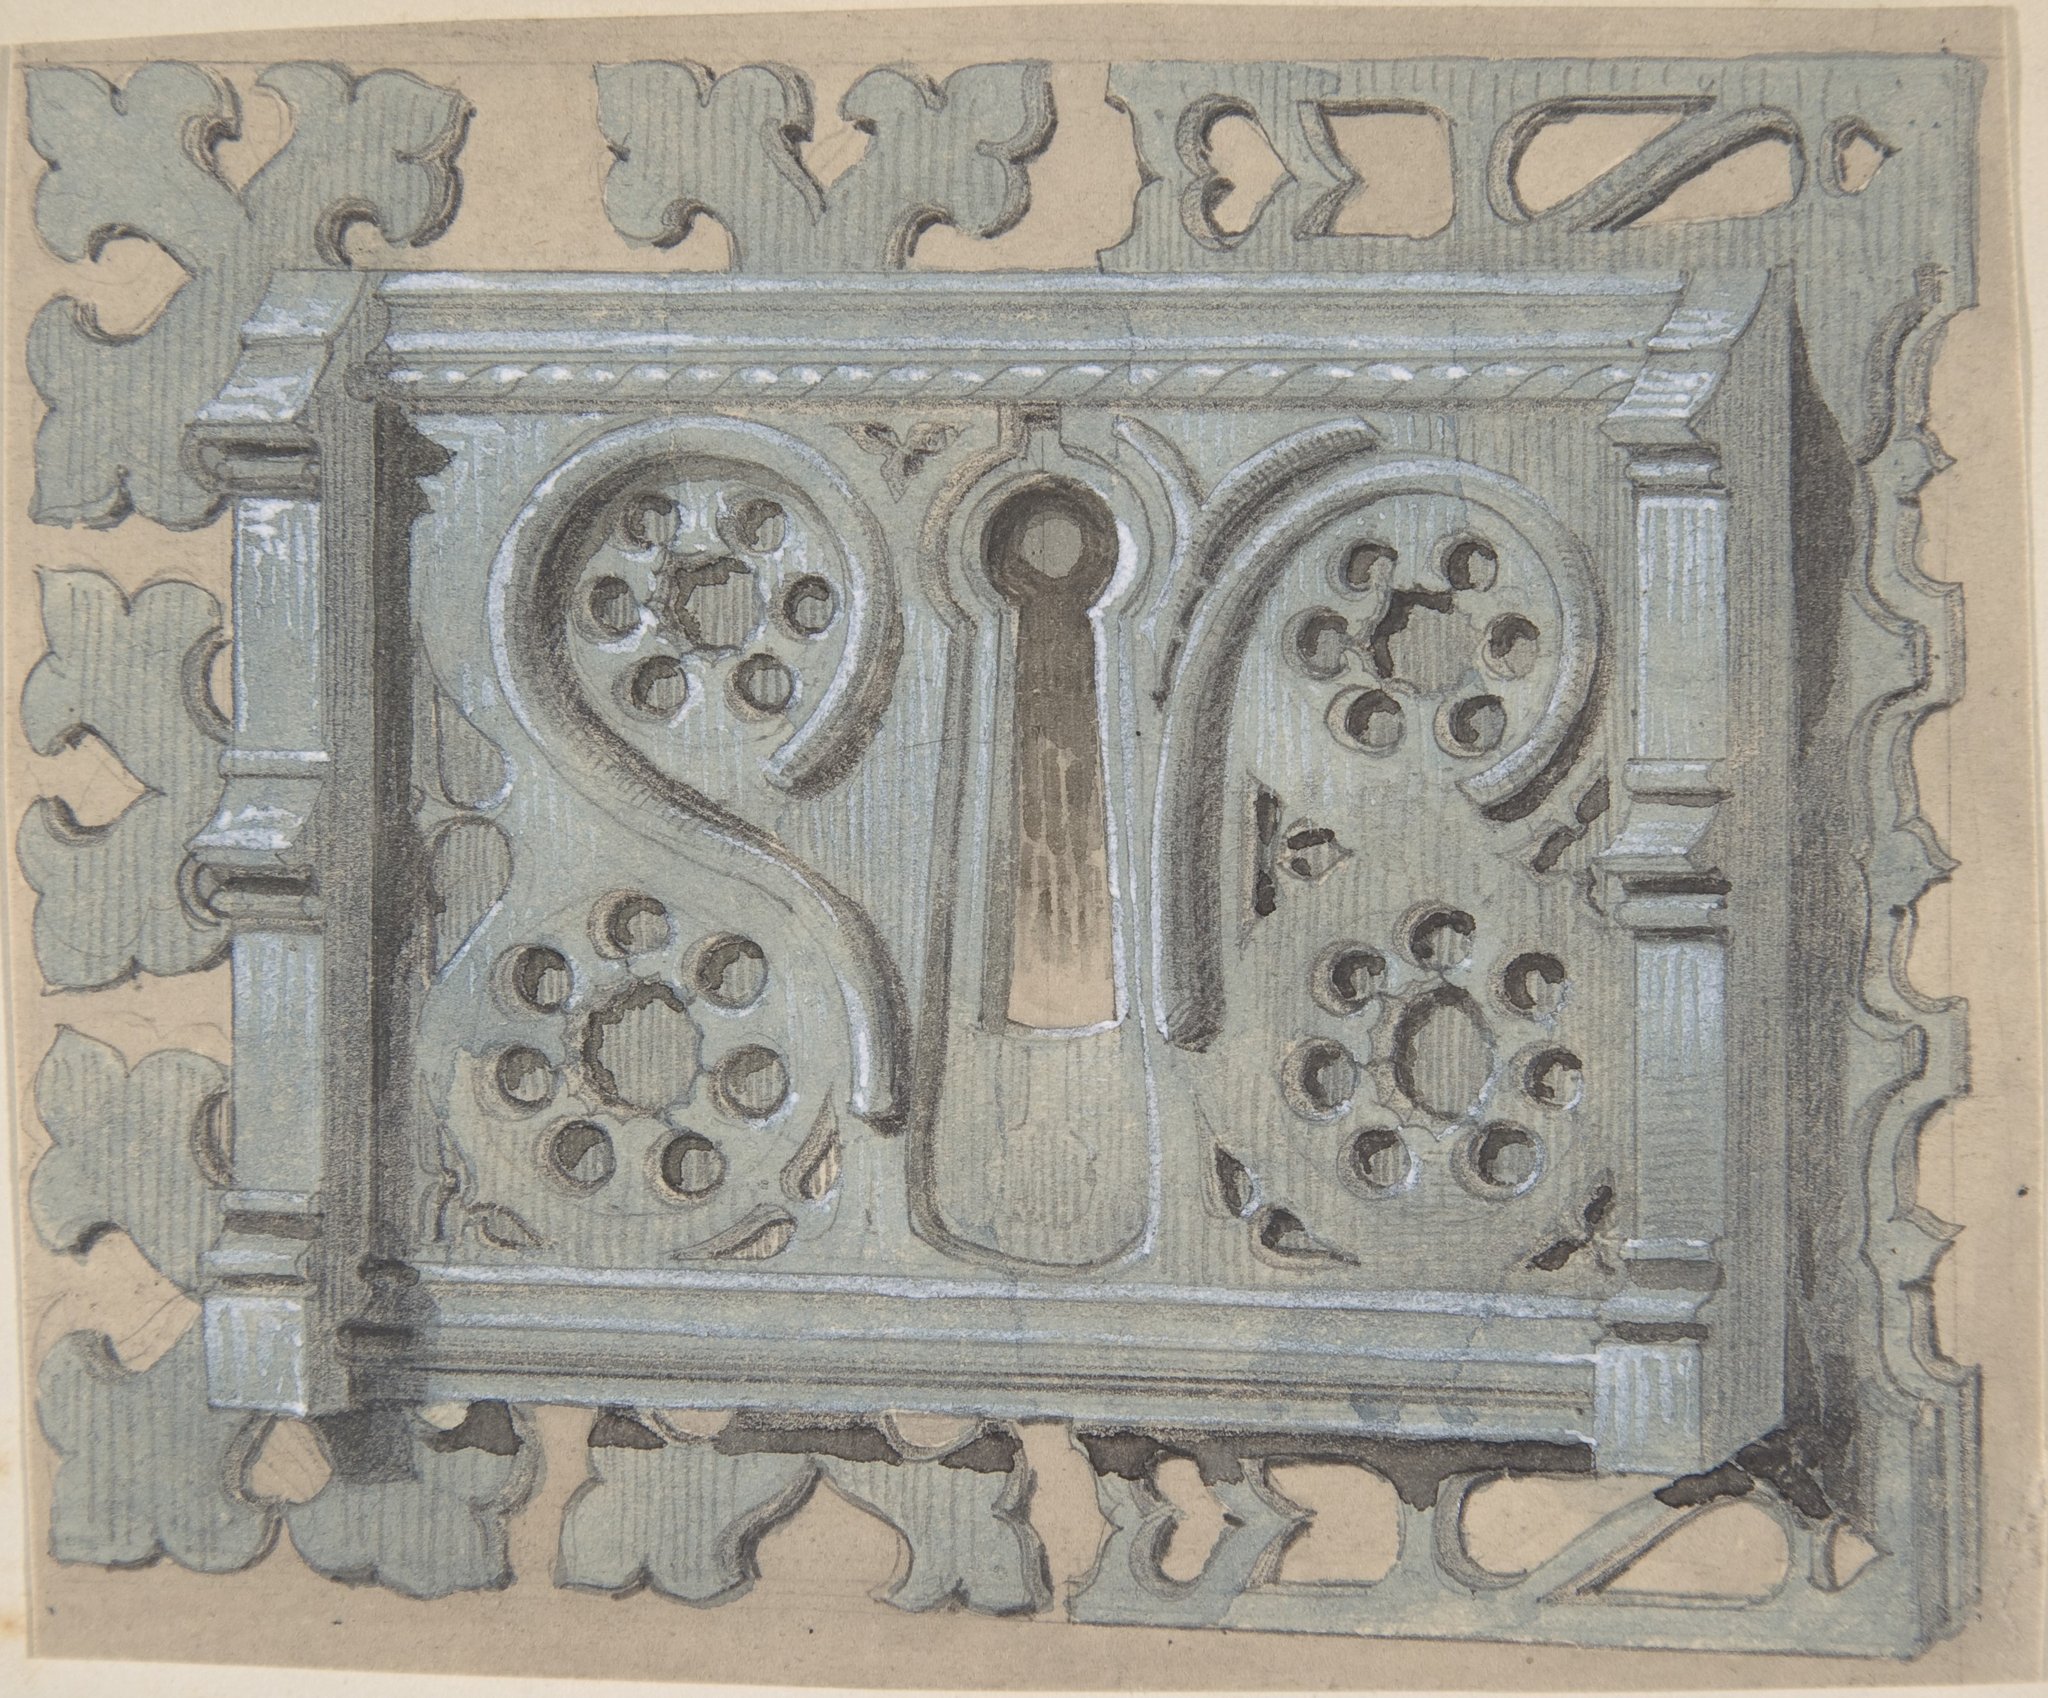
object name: drawing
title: Metal Keyplate for Church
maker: anonymous, british, 19th century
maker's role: artist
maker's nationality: british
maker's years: 1800-1900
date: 1851-1900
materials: gouache